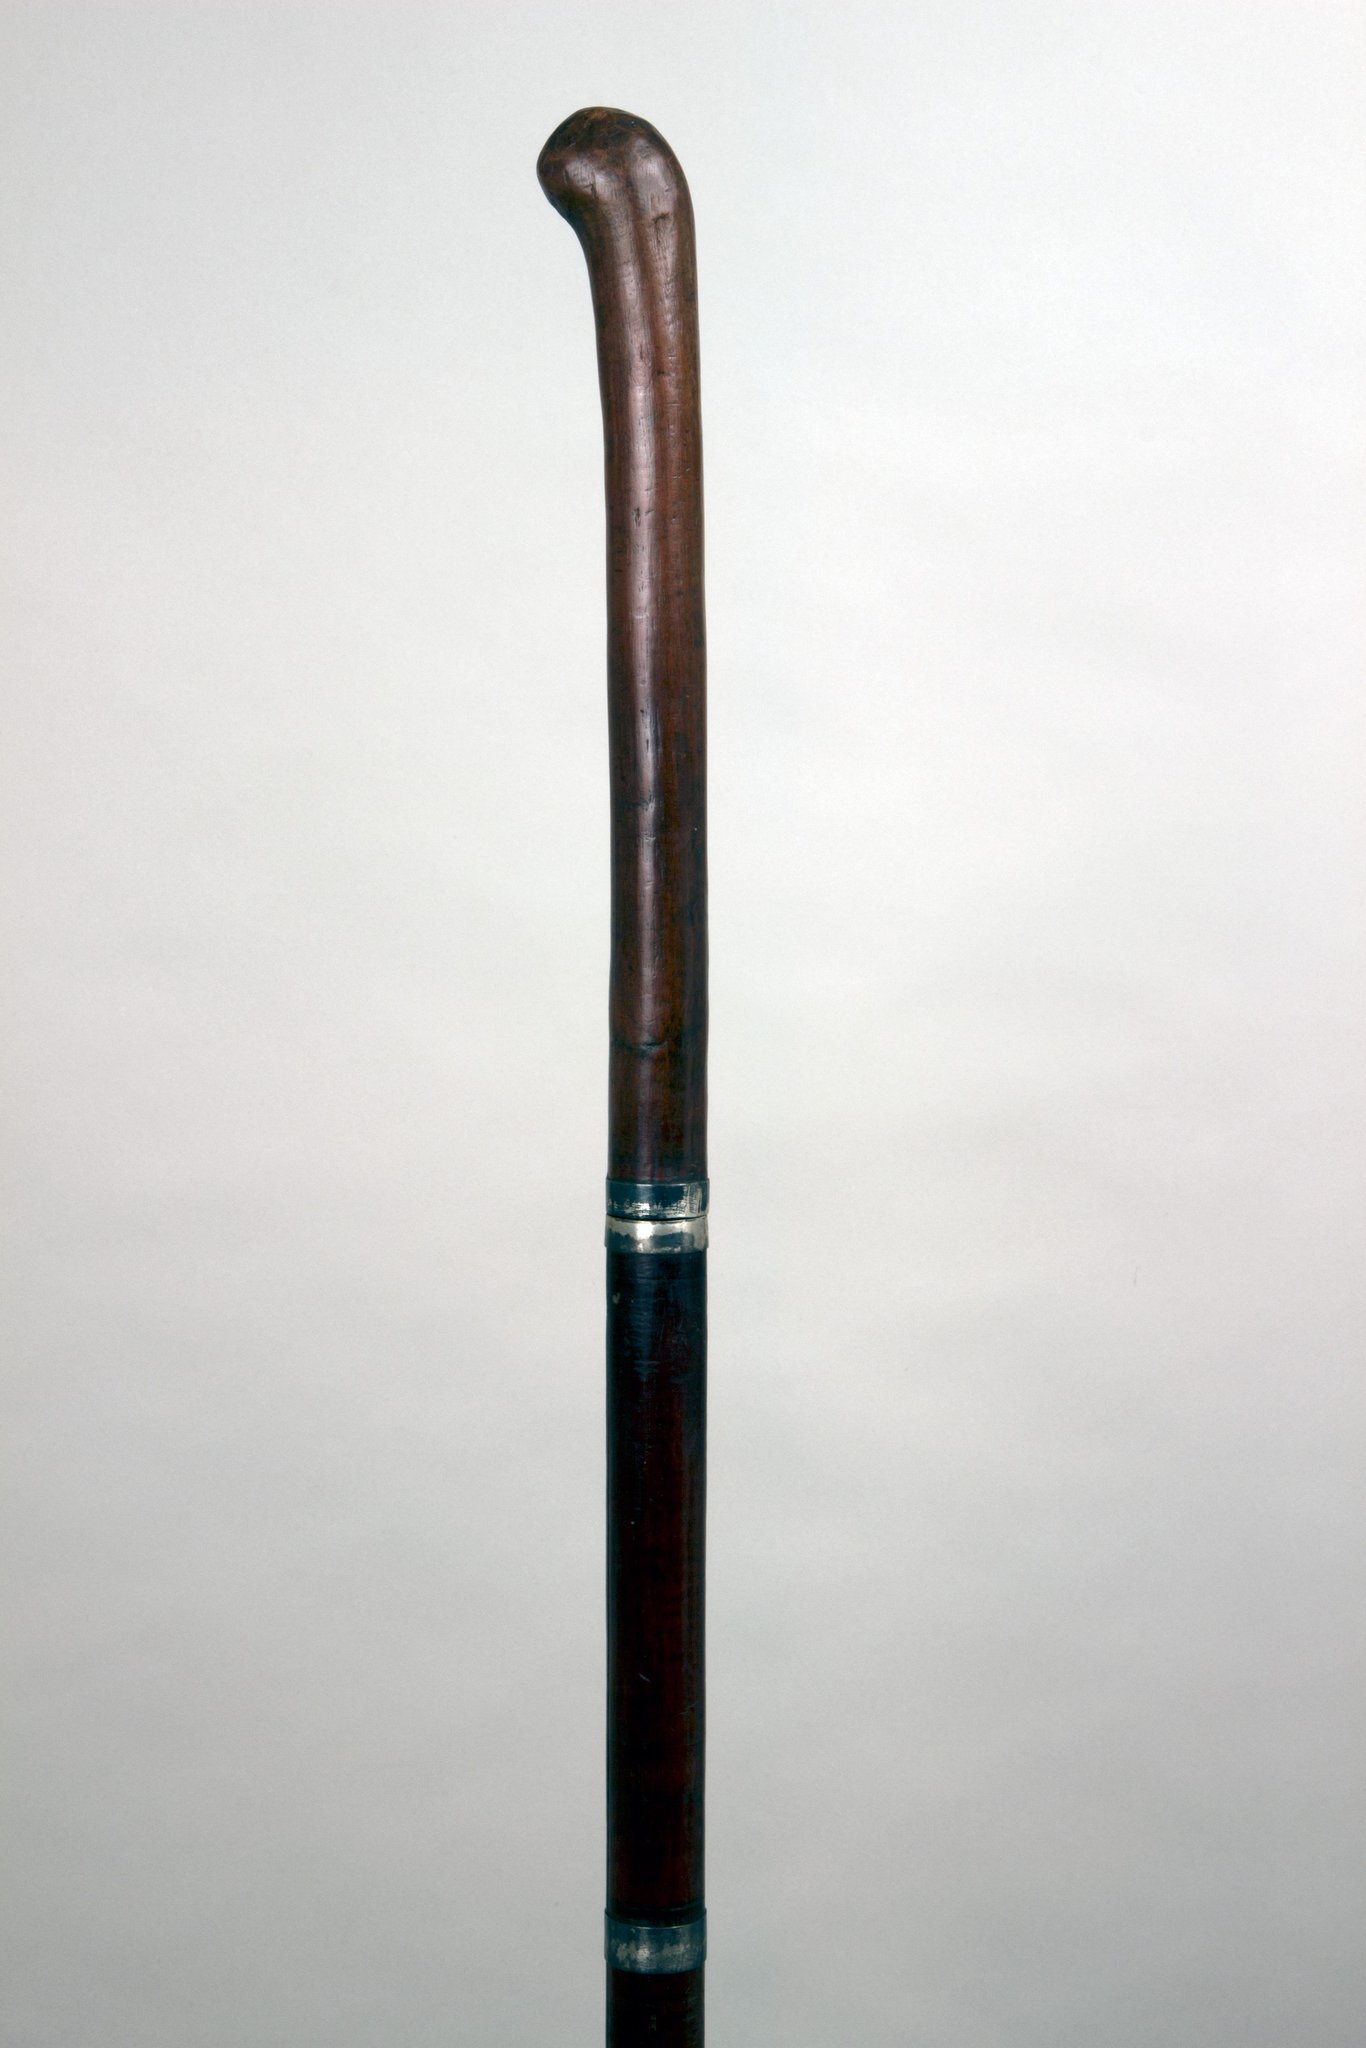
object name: sword cane with two blade and sheath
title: Sword Cane with Two Blades and Sheath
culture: burmese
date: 1801-1900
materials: silver, wood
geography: burma